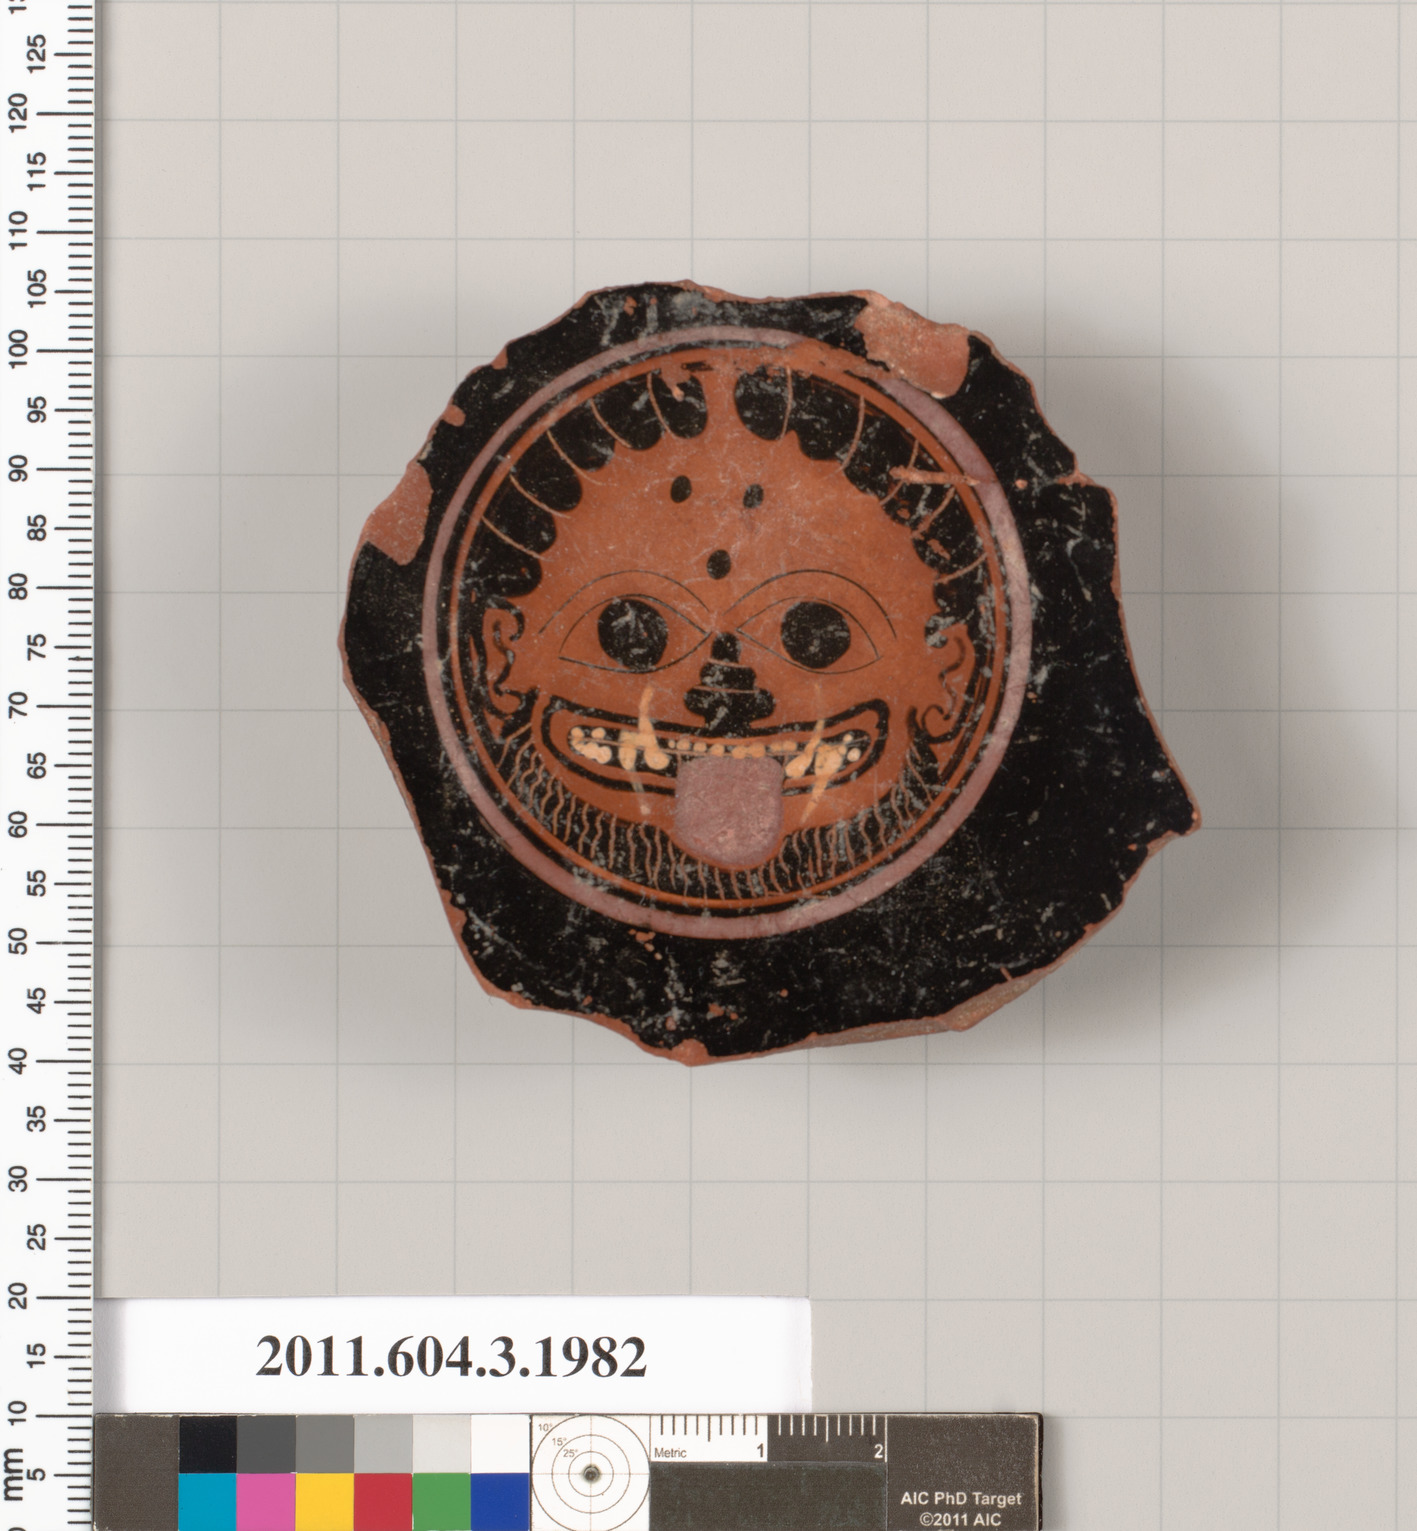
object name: kylix fragment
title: Terracotta fragment of a kylix (drinking cup)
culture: greek, attic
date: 550-526 BCE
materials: terracotta